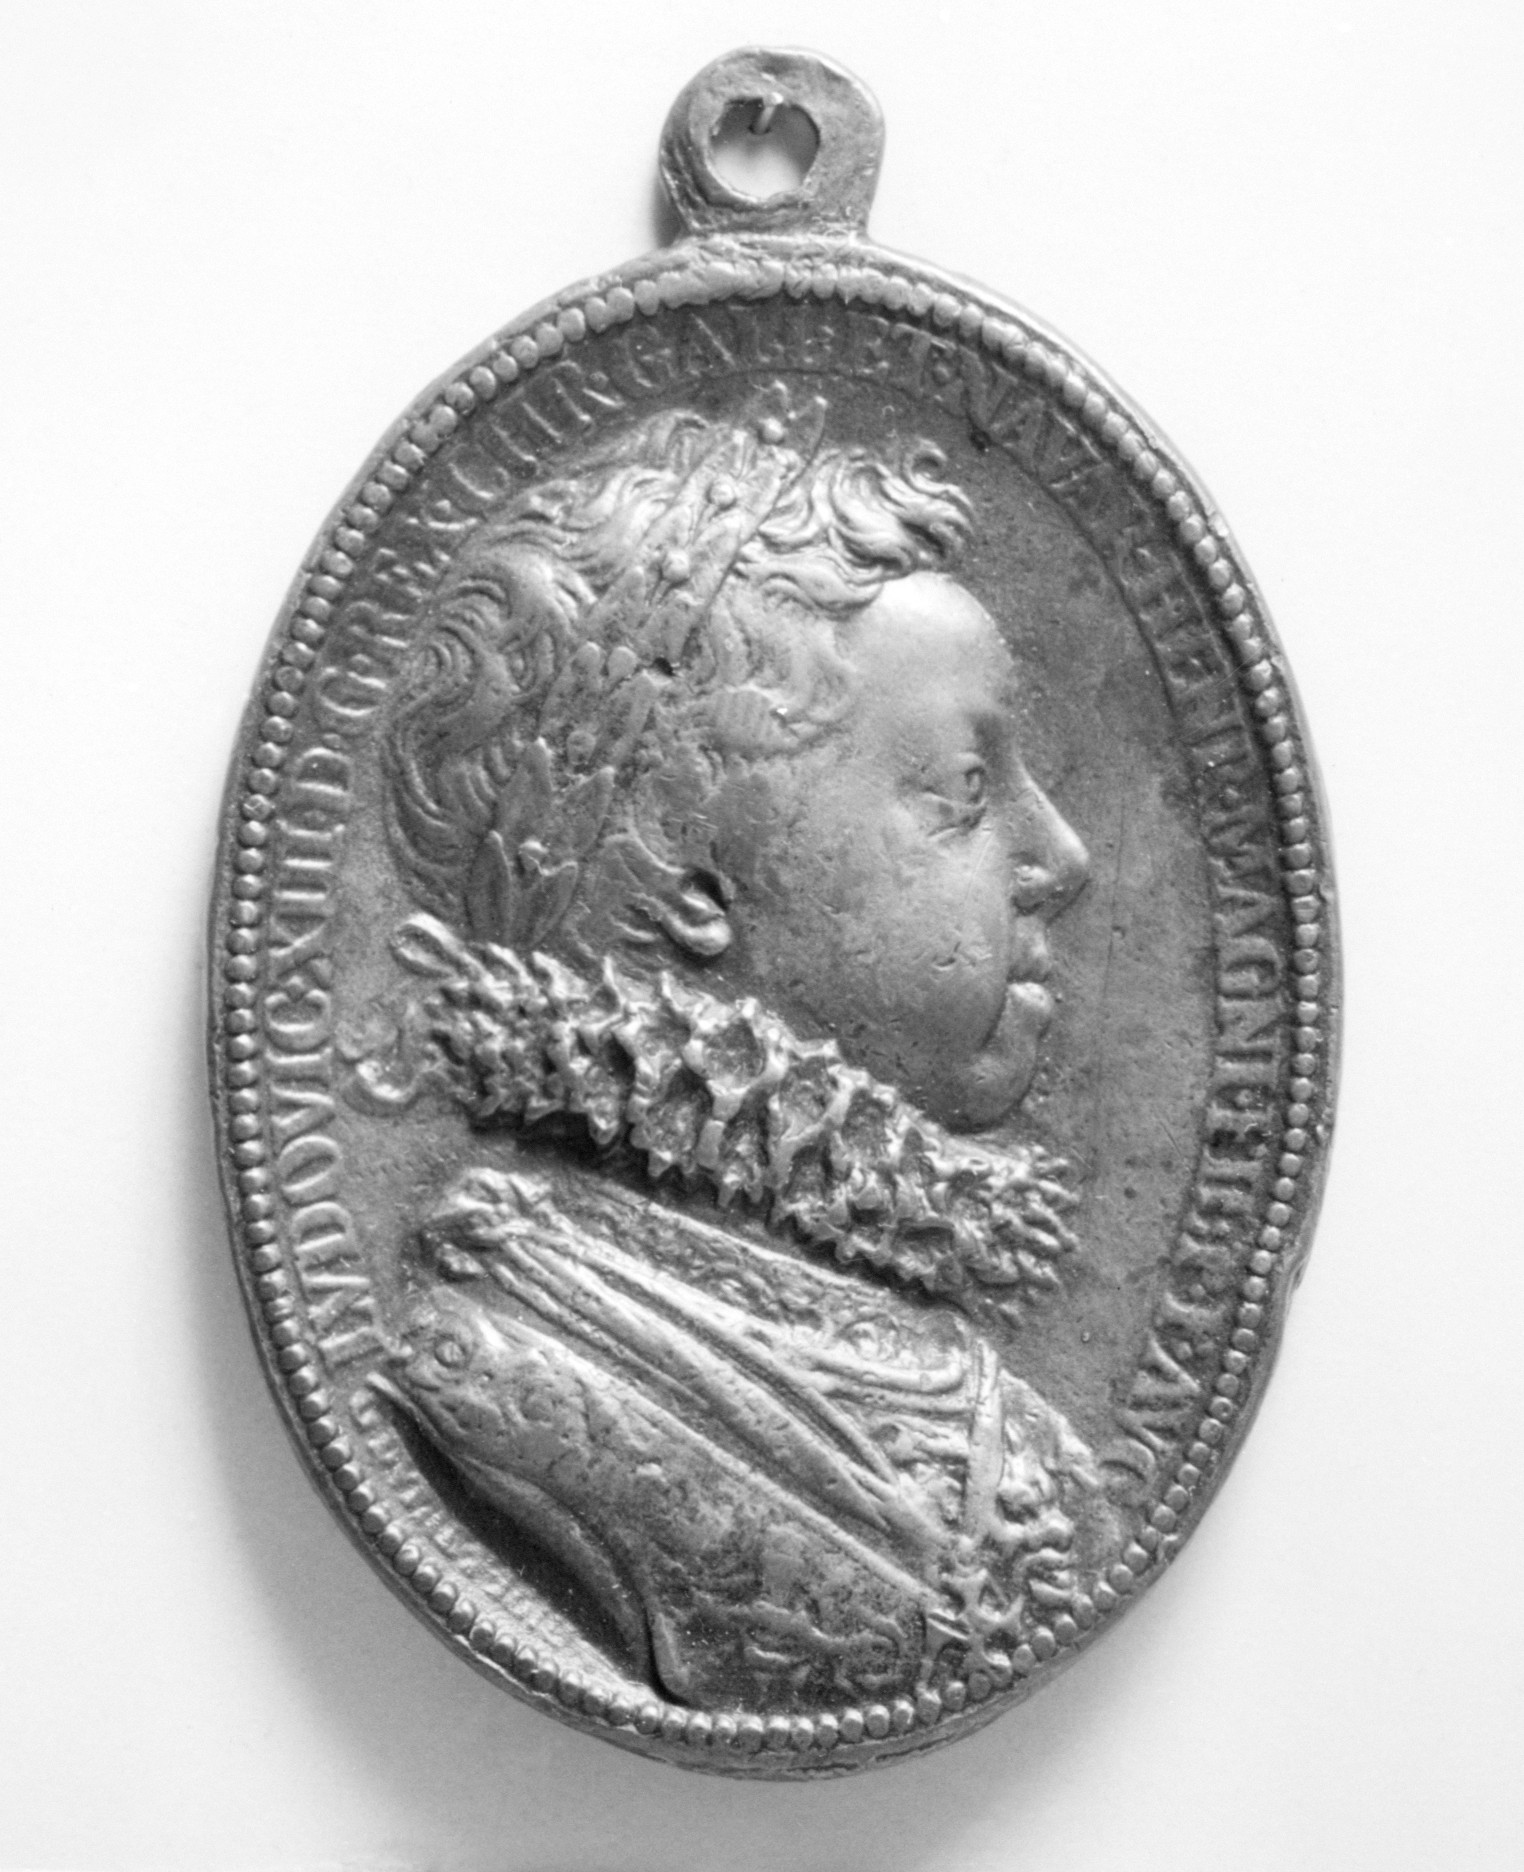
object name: medal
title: Louis XIII, King of France (b. 1601, r. 1610–43)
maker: guillaume dupré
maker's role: artist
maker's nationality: french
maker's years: 1579-1640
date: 1610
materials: bronze, patina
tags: kings,men,profiles